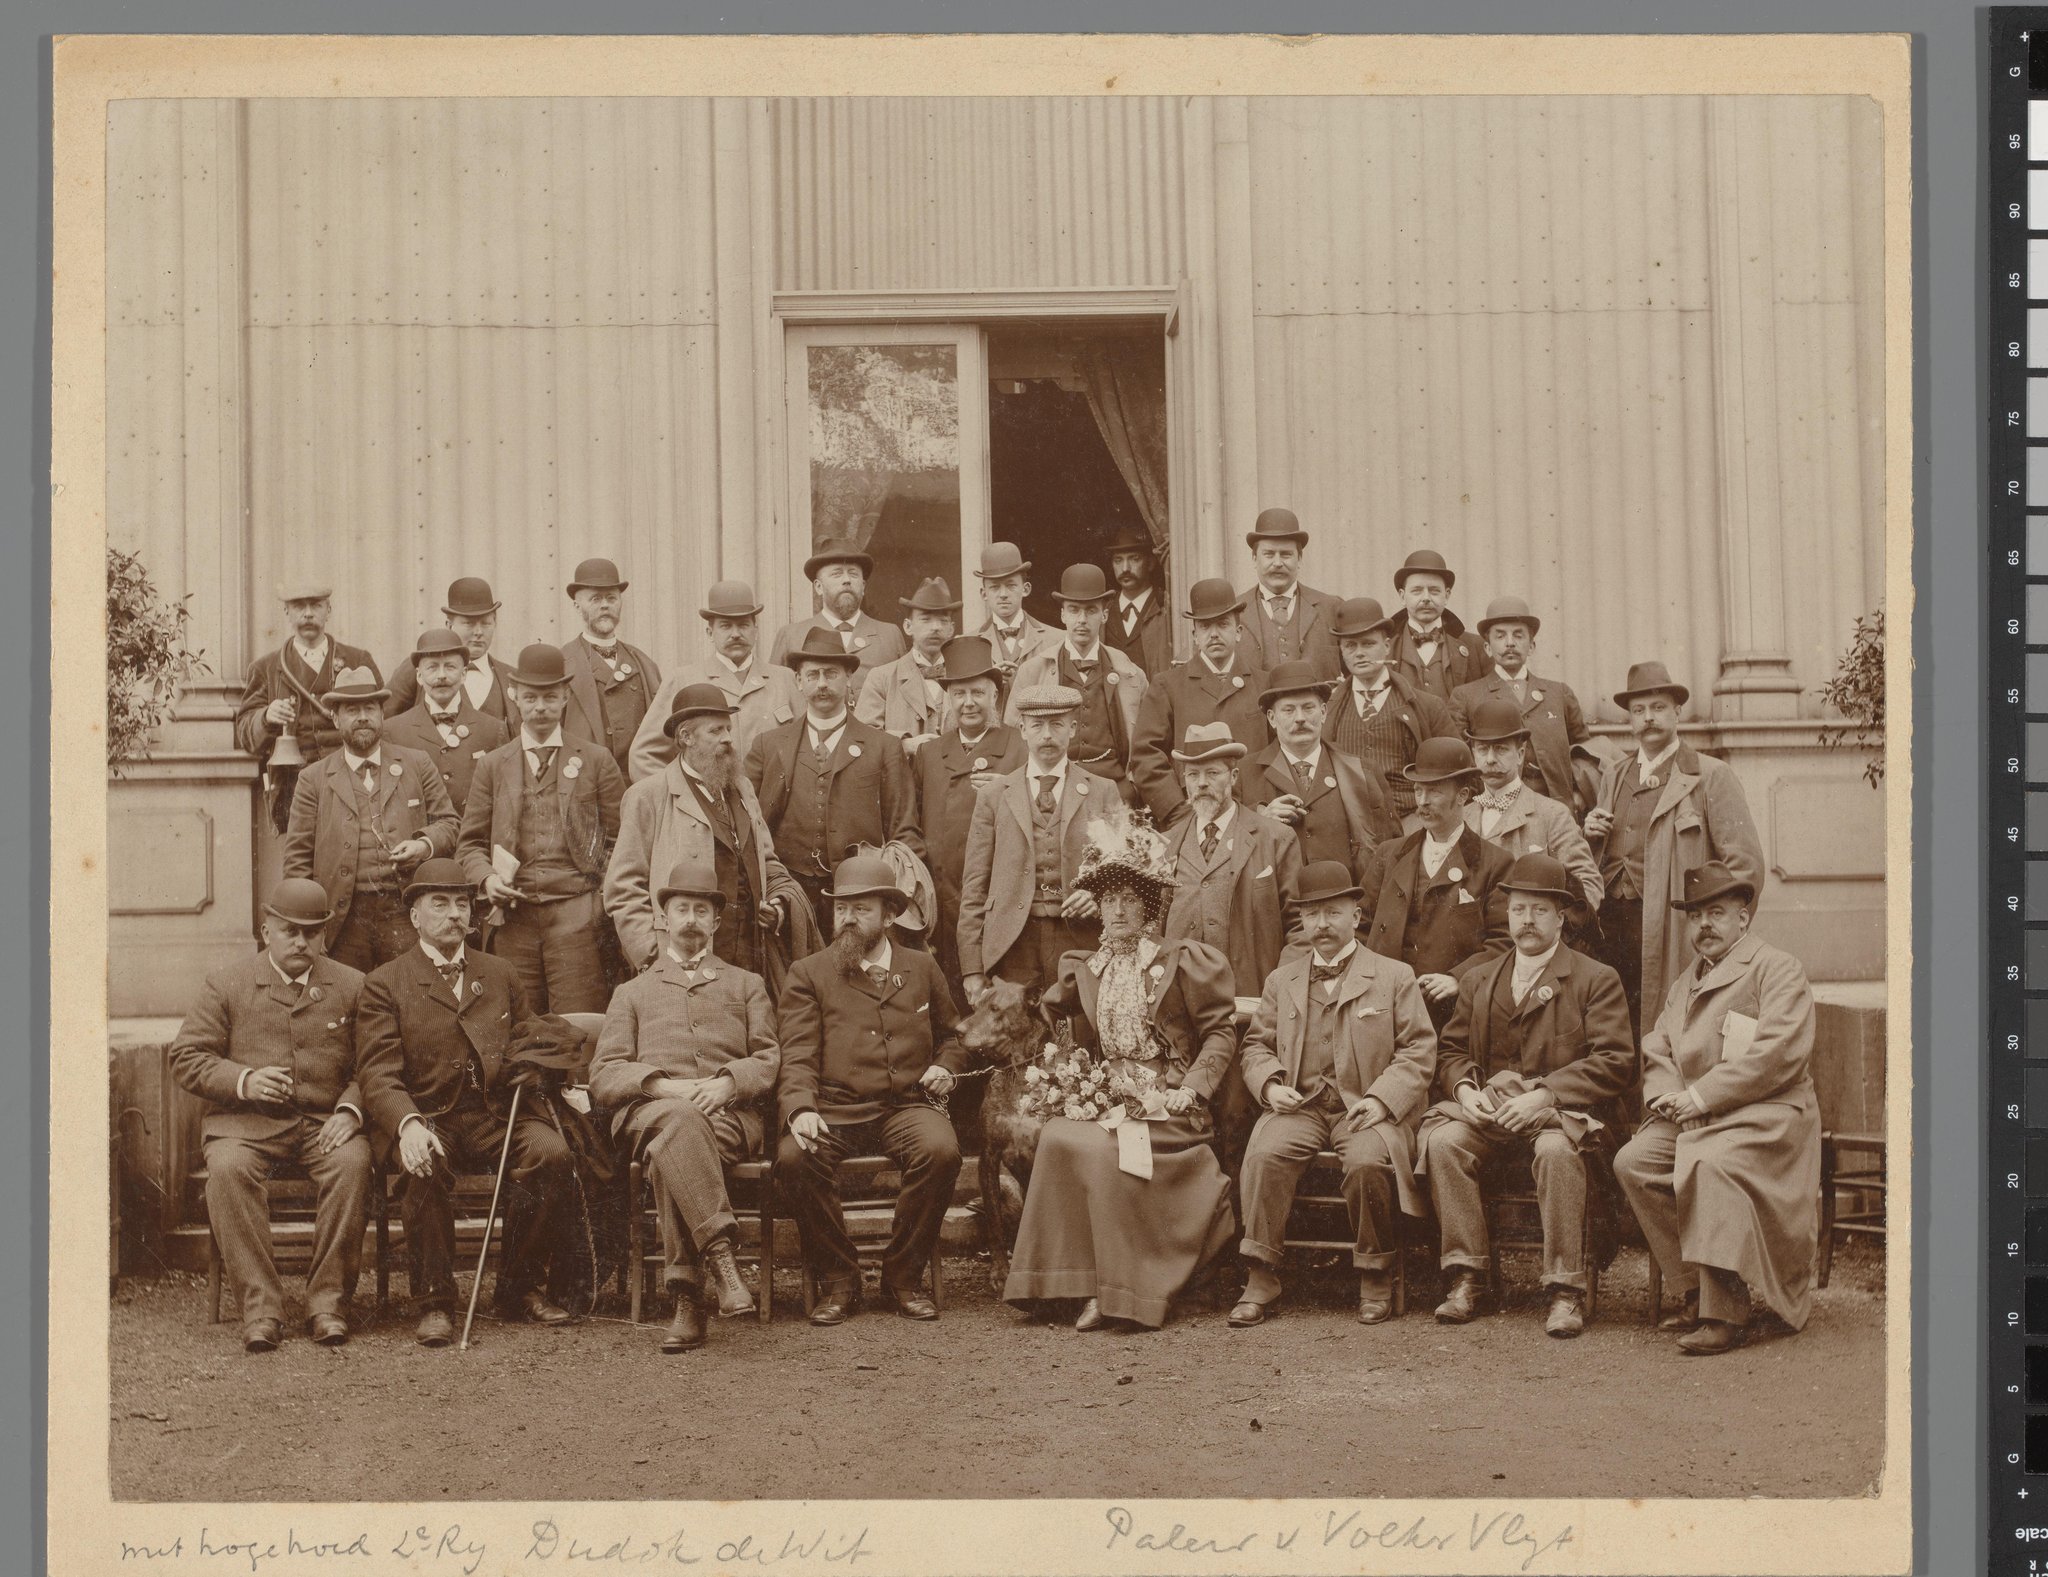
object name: photograph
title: Paleis v. Volksvlijt/met hoge hoed 2e Rij Dudok de Wit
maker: Anonymous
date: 1880-1910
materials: cardboard, photographic support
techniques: collodion silver print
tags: paleis voor volksvlijt